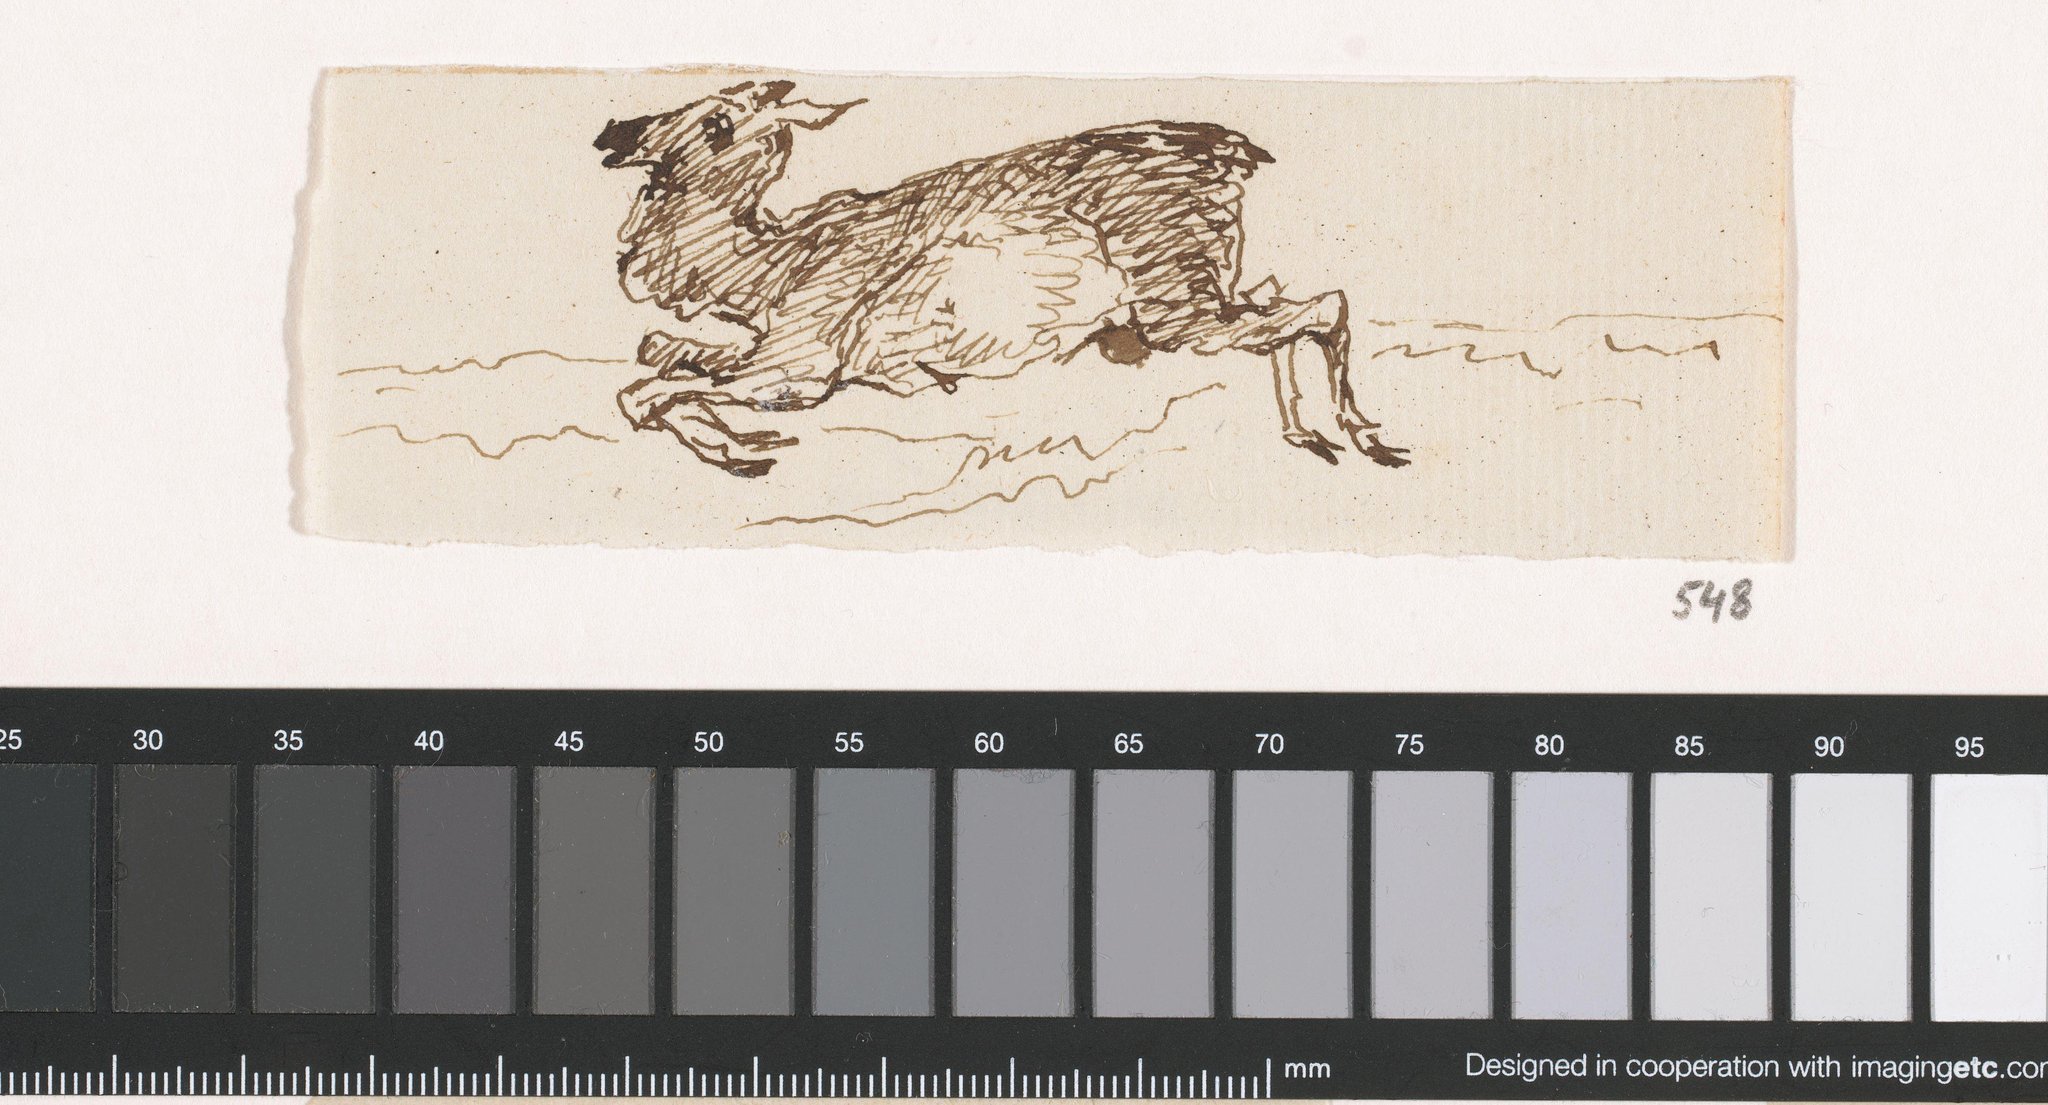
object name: drawing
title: Hert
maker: johannes tavenraat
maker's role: draughtsman, painter, print maker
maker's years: 1809-1881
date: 1840-1880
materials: ink, paper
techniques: pen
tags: hoofed animals: deer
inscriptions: collector's mark: Lugt 2228